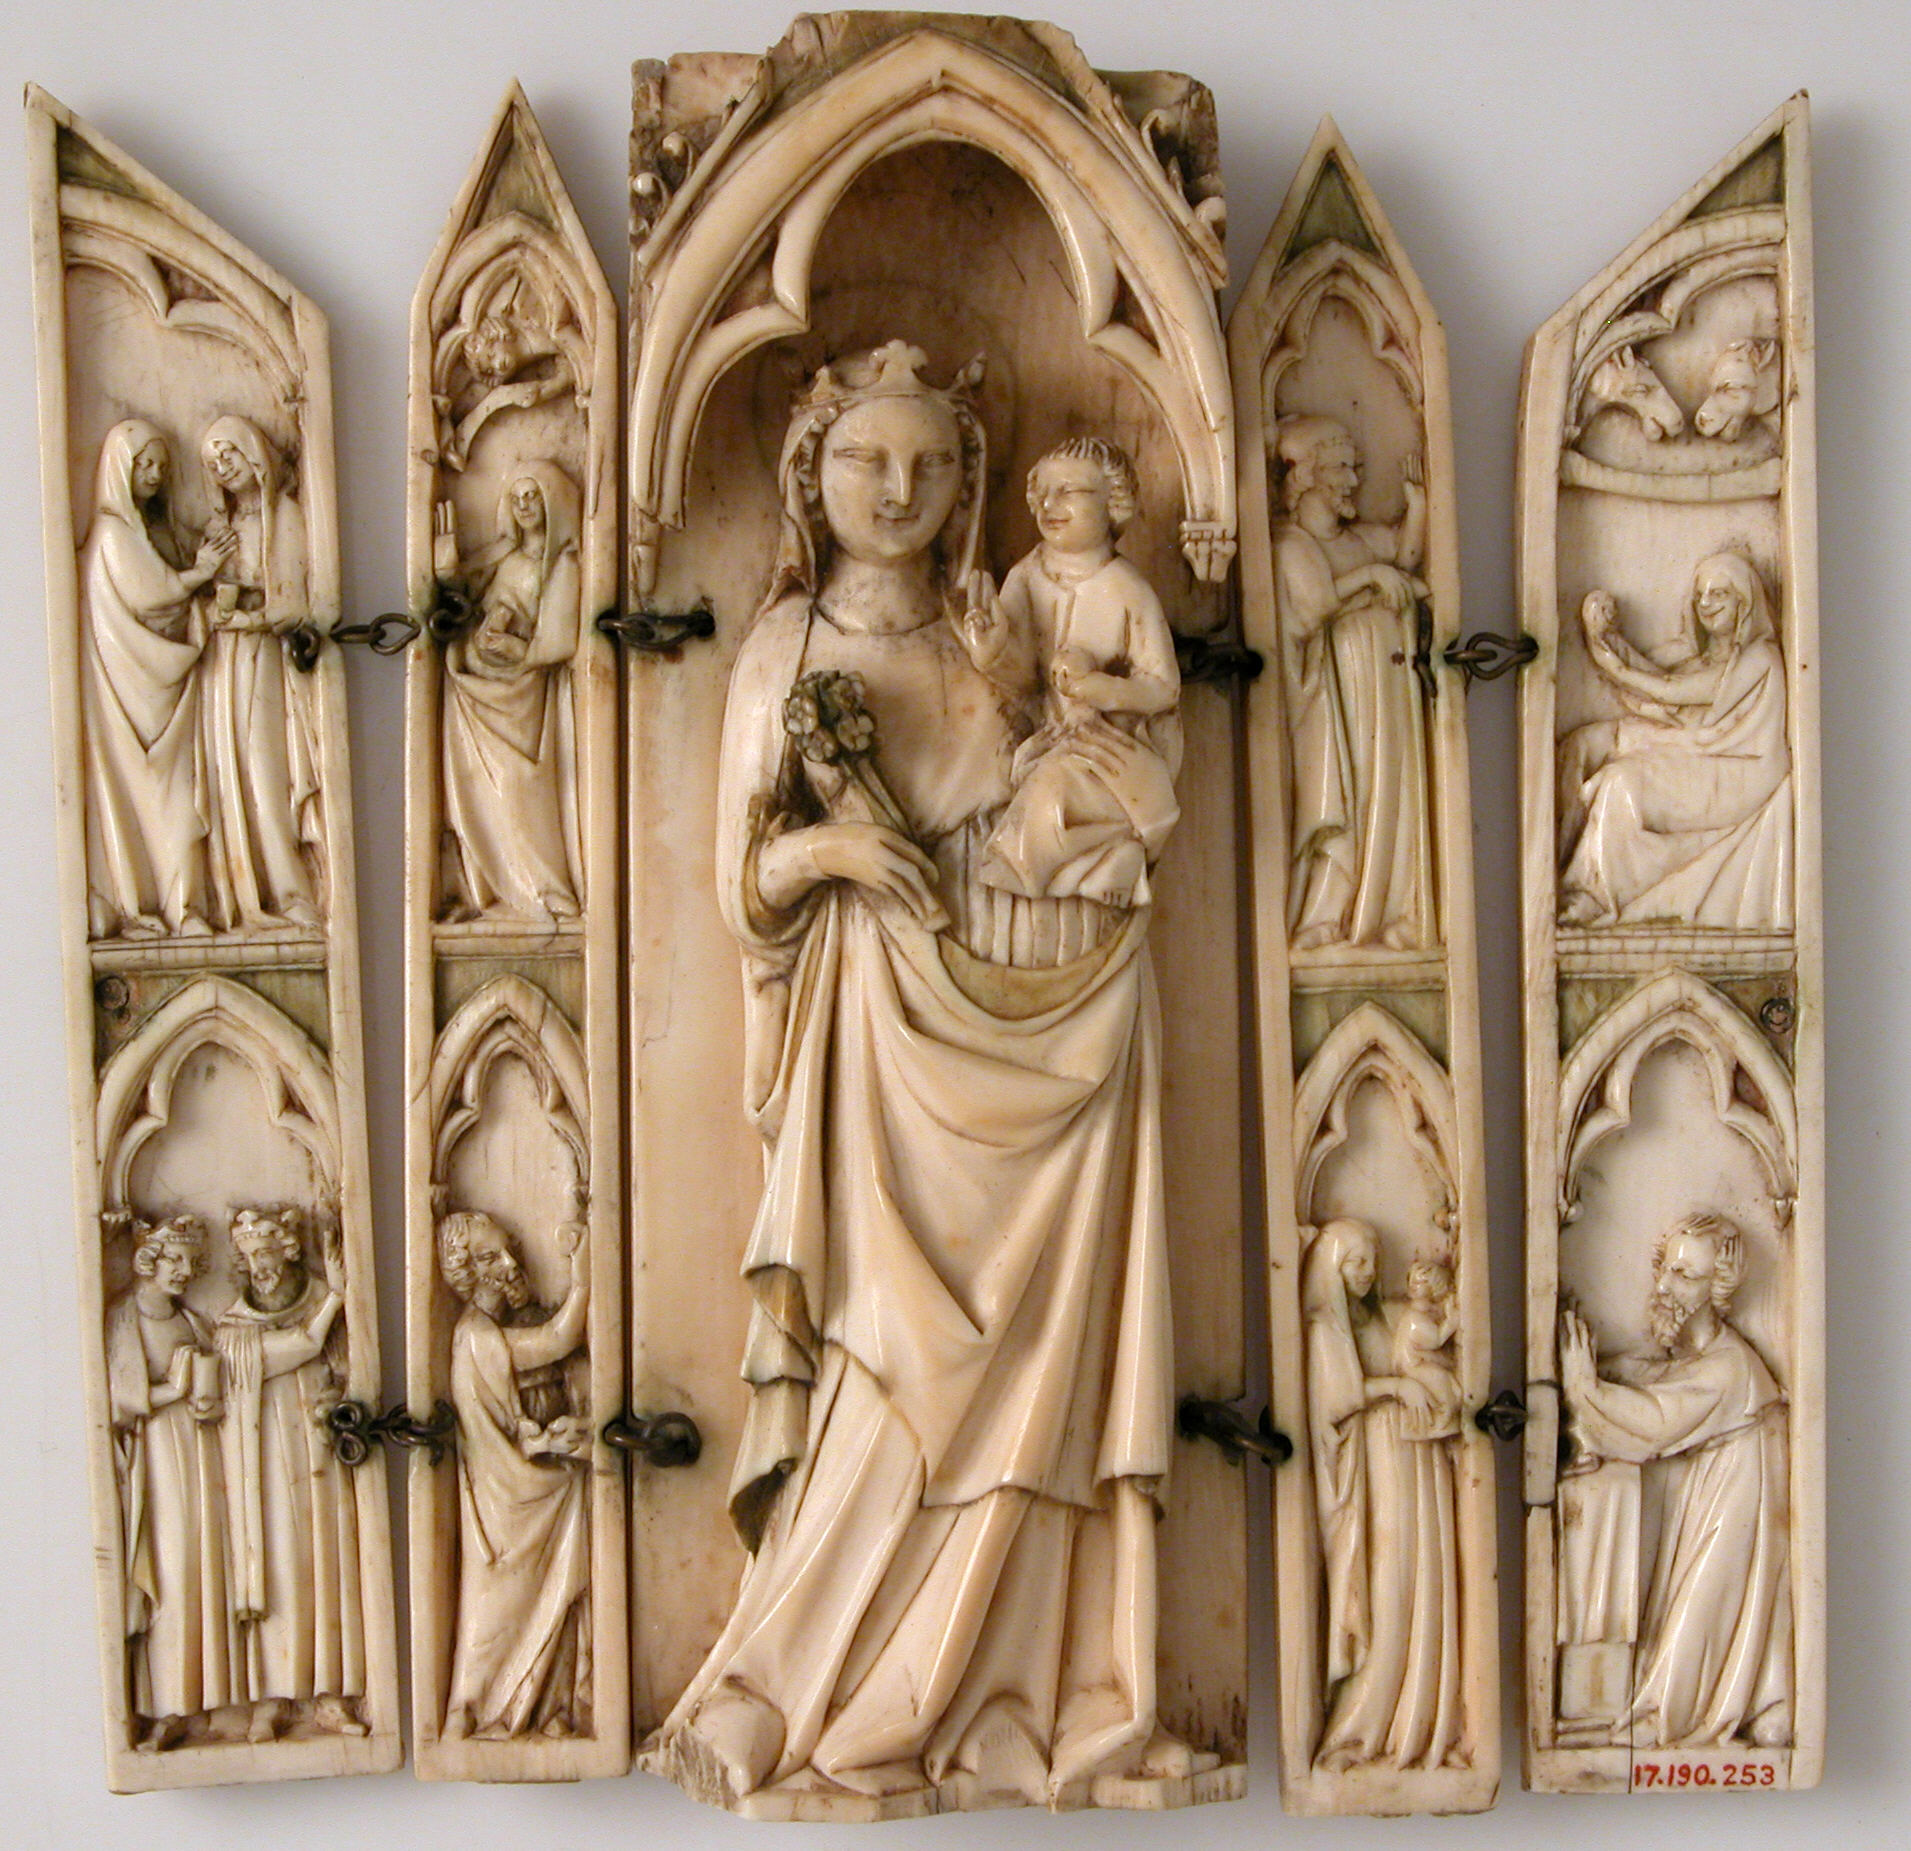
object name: folding shrine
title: Folding Shrine with Virgin and Child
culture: french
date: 1301-1400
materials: ivory, metal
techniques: polychromy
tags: men,women,saints